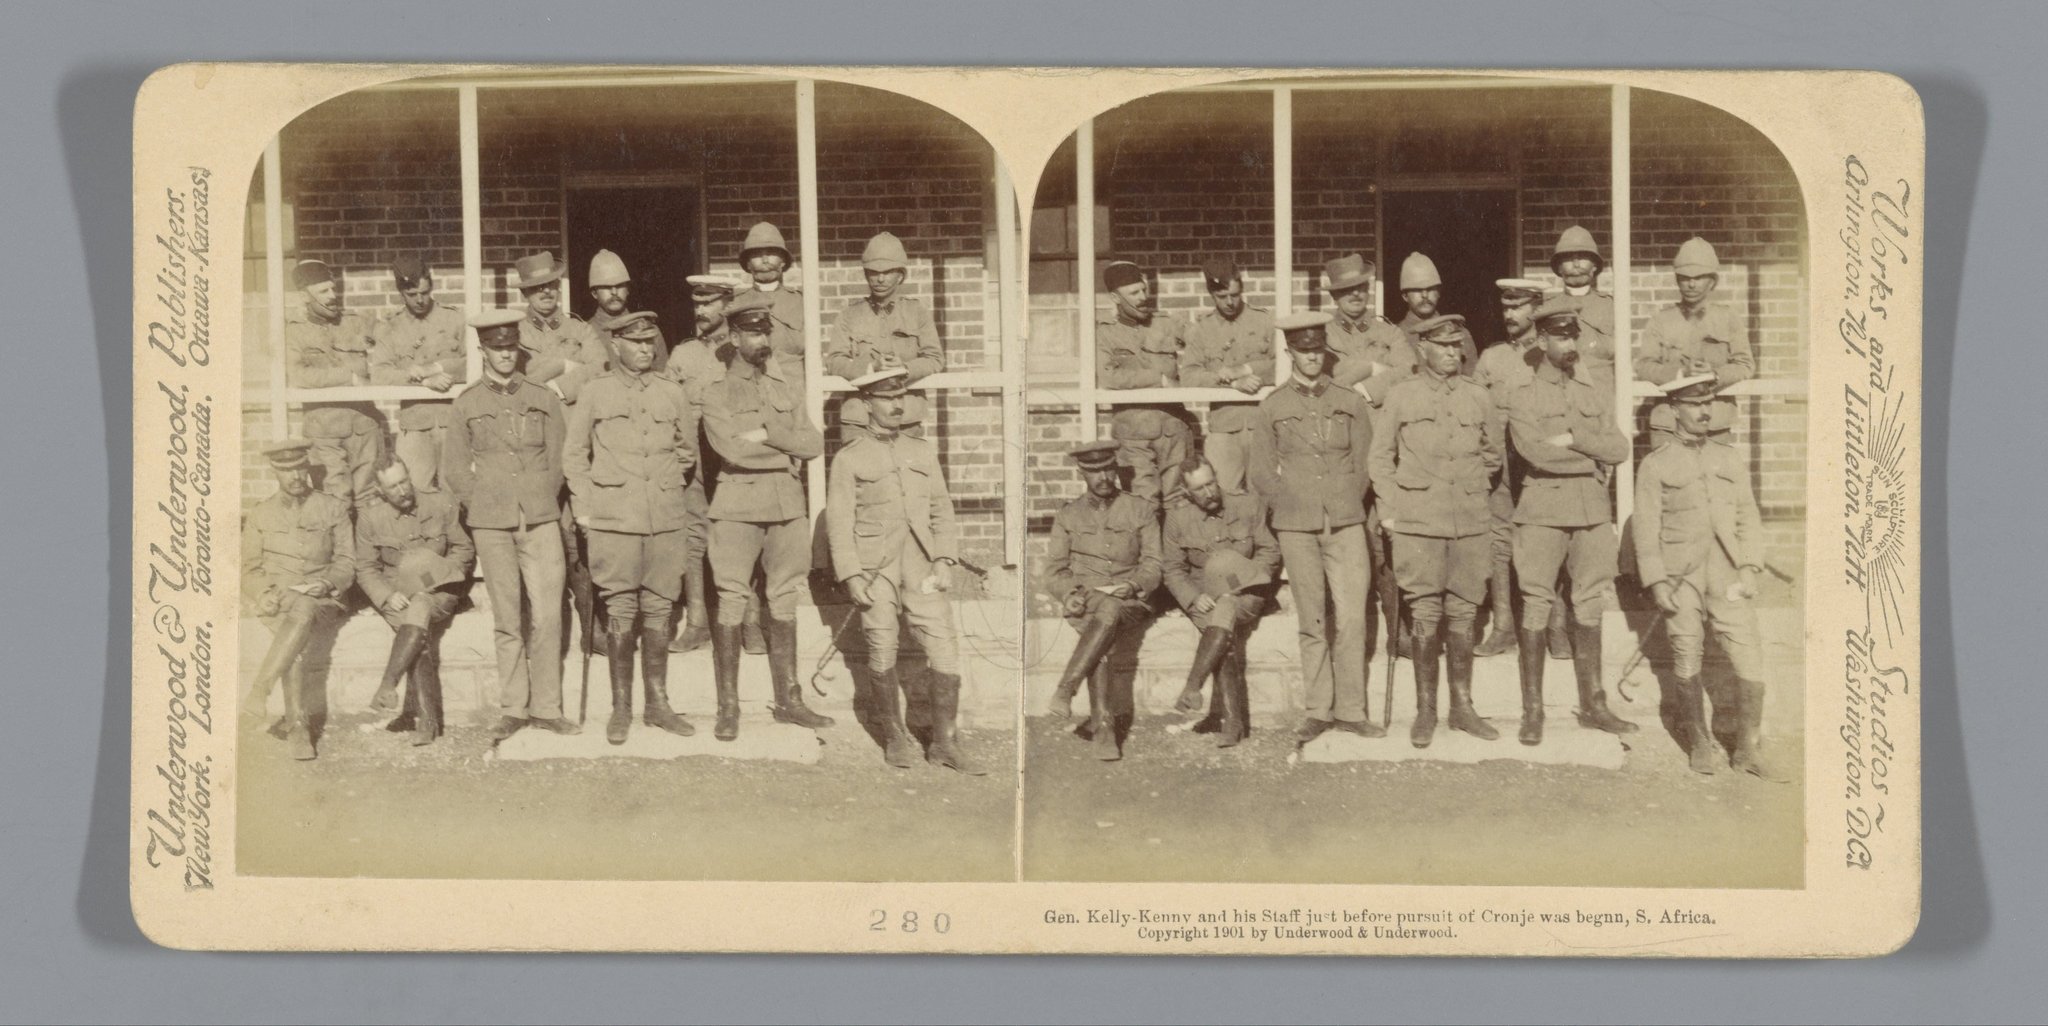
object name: stereograph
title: Generaal Thomas Kelly-Kenny en zijn staff voor de slag van Paardeberg, Zuid-Afrika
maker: Anonymous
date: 1901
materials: cardboard, paper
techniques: albumen print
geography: new york city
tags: commander-in-chief, general, marshal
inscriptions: inscription: ‘Works and Studios ~/ Arlington, N.J. Littleton, N.H. Washington, D.C.’, number: ‘280’, copyright notice: ‘Copyright 1901 by Underwood & Underwood.’, inscription